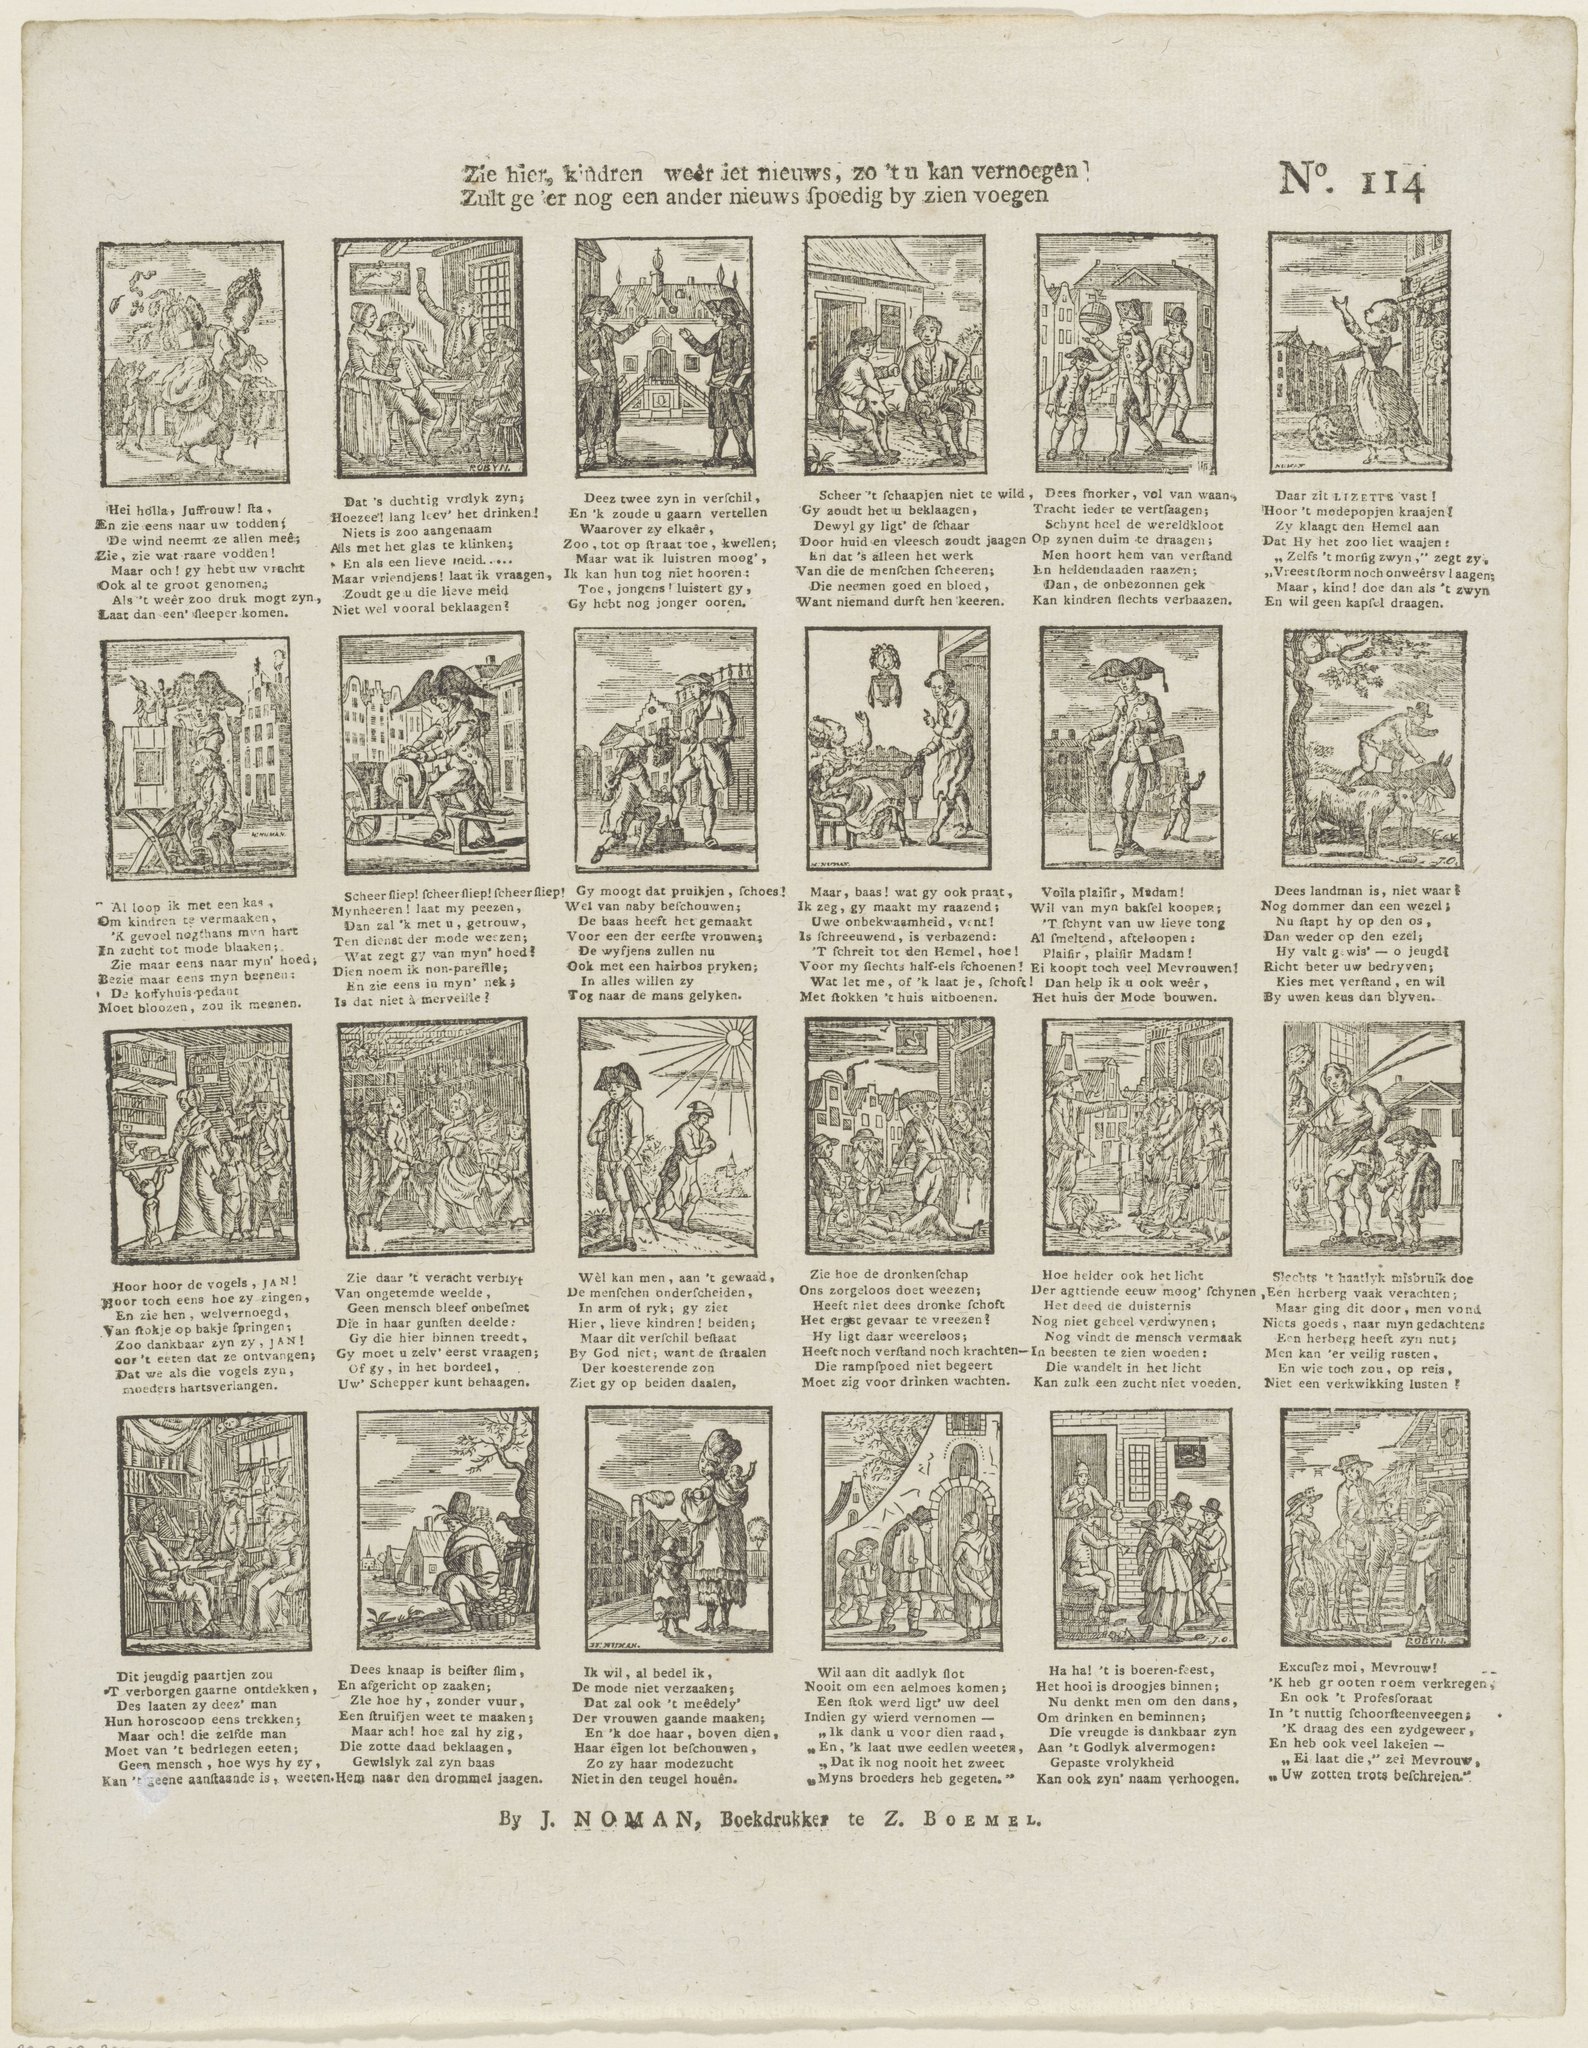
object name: popular print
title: Zie hier, kindren weêr iets nieuws, zo 't u kan vernoegen / Zult ge 'er nog een ander nieuws spoedig by zien voegen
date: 1806-1830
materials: paper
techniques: letterpress printing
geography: netherlands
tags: brothel, human types, drunkenness, puppet and marionette show, shearing (sheep)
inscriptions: collector's mark: Lugt 2760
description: Blad met 24 voorstellingen van verschillende figuren en bezigheden. Onder elke afbeelding een achtregelig vers. Genummerd rechtsboven: No. 114.